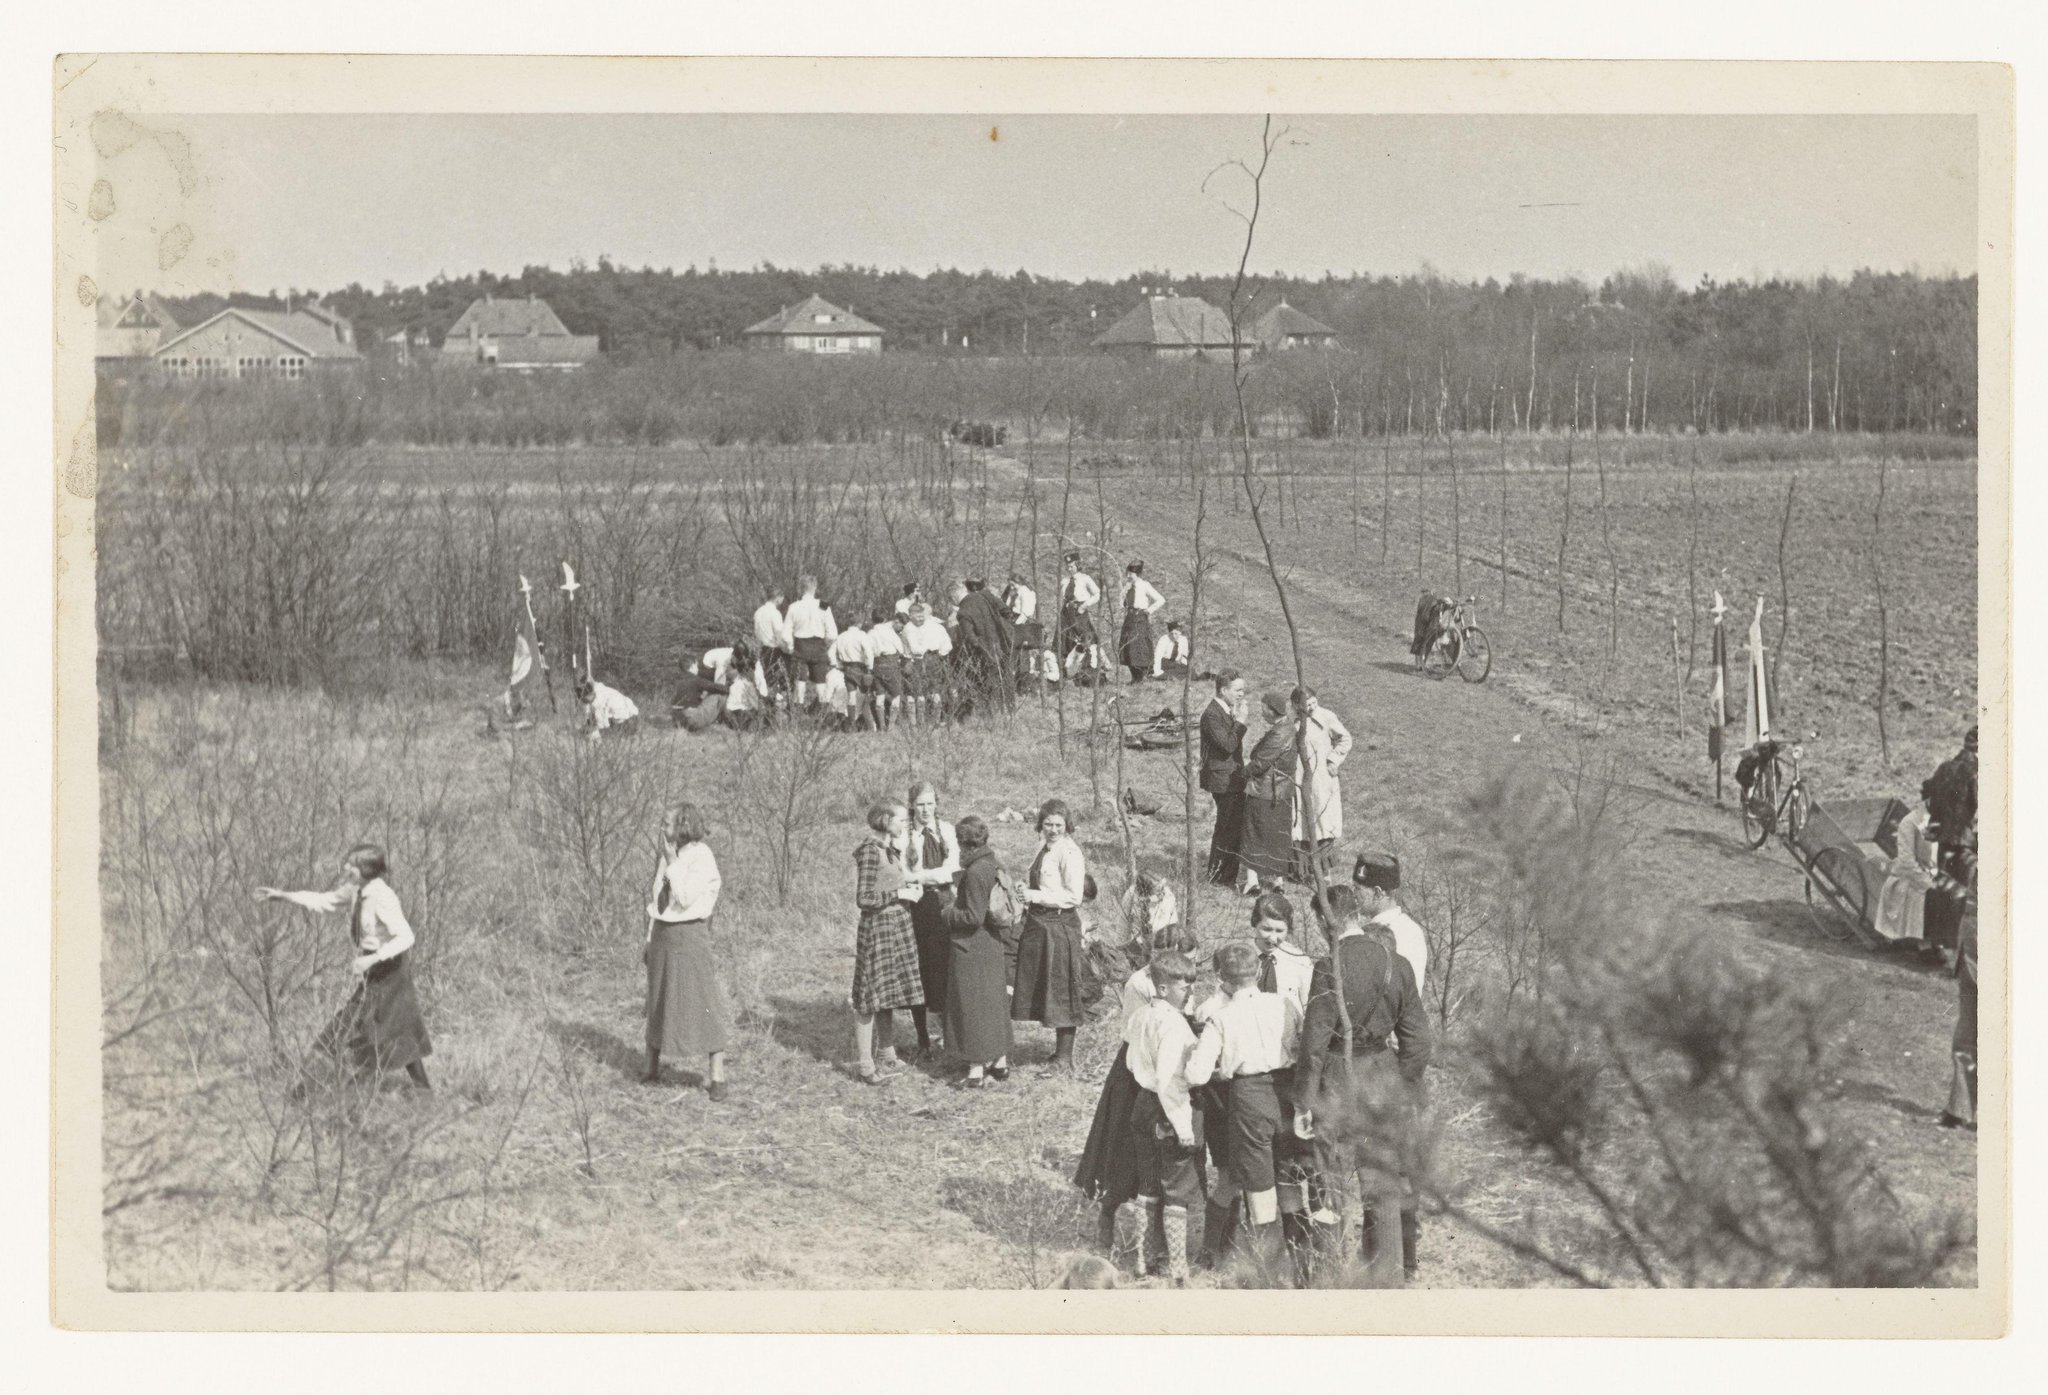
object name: photograph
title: Jeugdstorm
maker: j. otto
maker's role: fotograaf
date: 1935-1937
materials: photographic support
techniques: gelatin silver print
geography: zeist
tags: military parade, pageant, zeist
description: Ergens buiten, vermoedelijk na afloop van de optocht, staan de Jeugdstormers in groepjes bij elkaar. Op een weg rechts staan wat fietsen.